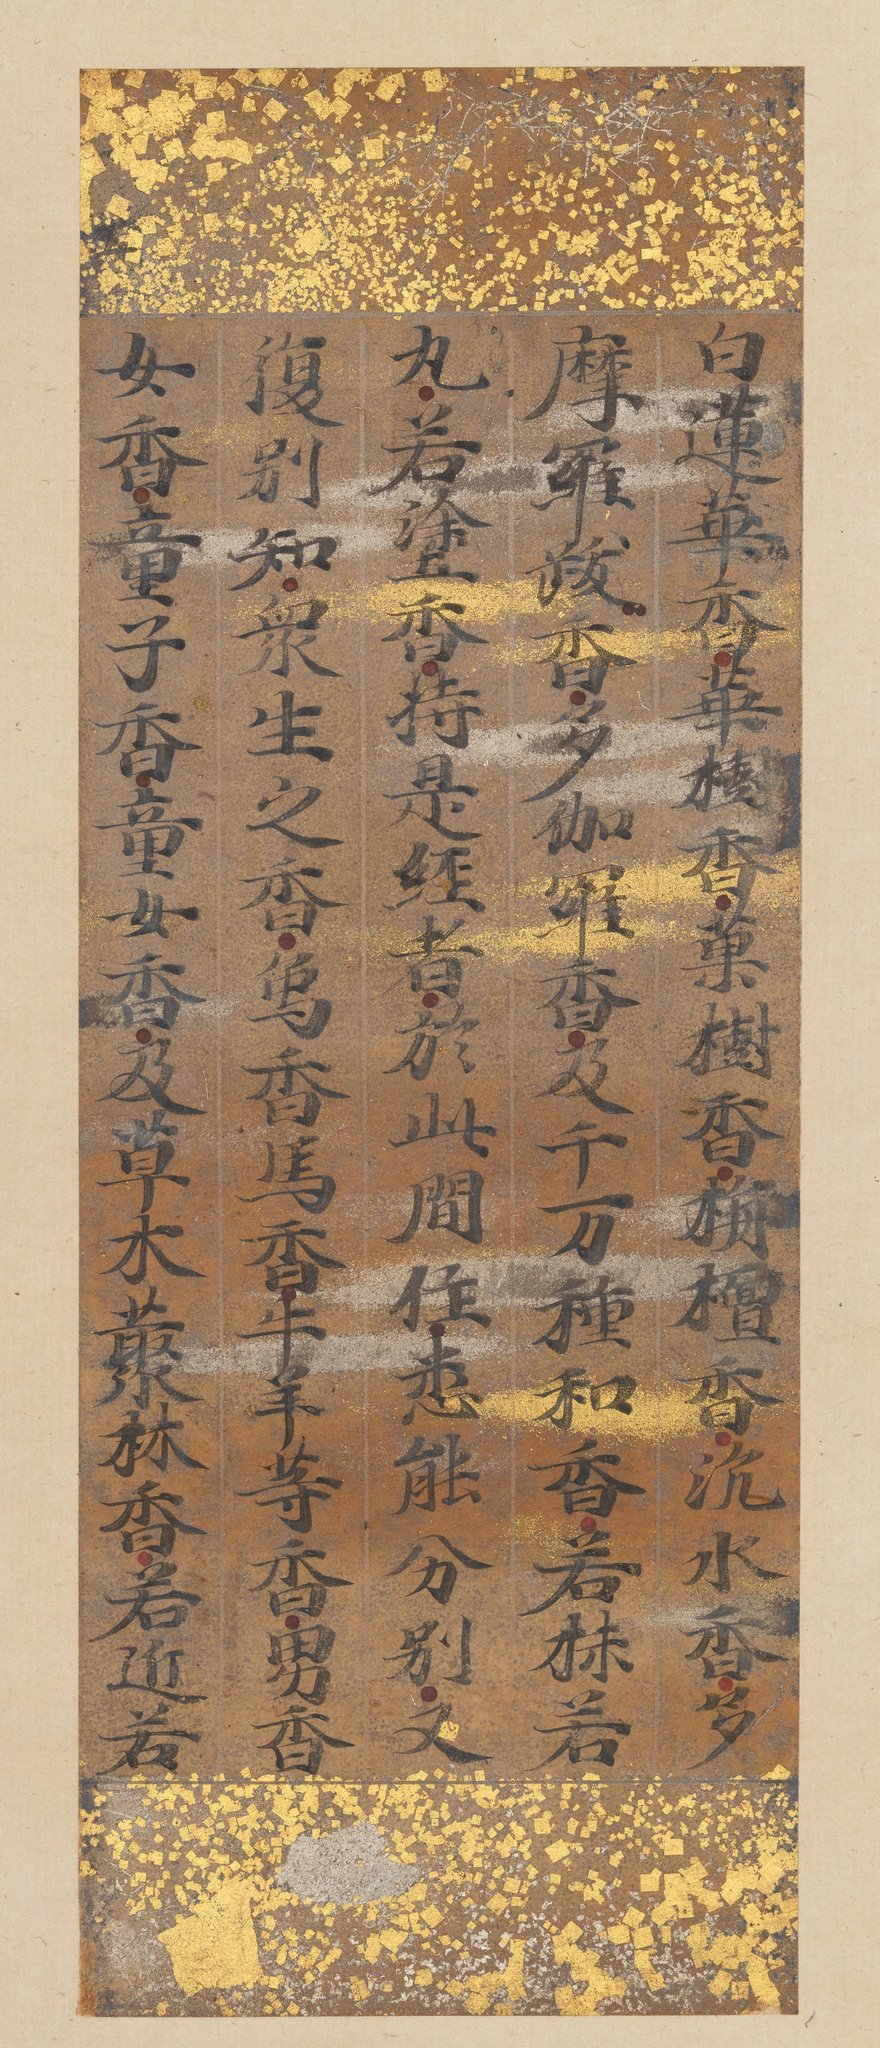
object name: hanging scroll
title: Segment of Chapter 19 of the Lotus Sutra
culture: japanese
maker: kujō kanezane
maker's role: artist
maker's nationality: japanese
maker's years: 1149-1207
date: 1167-1200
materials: gold, ink, paper, silver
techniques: cutting, kirikane